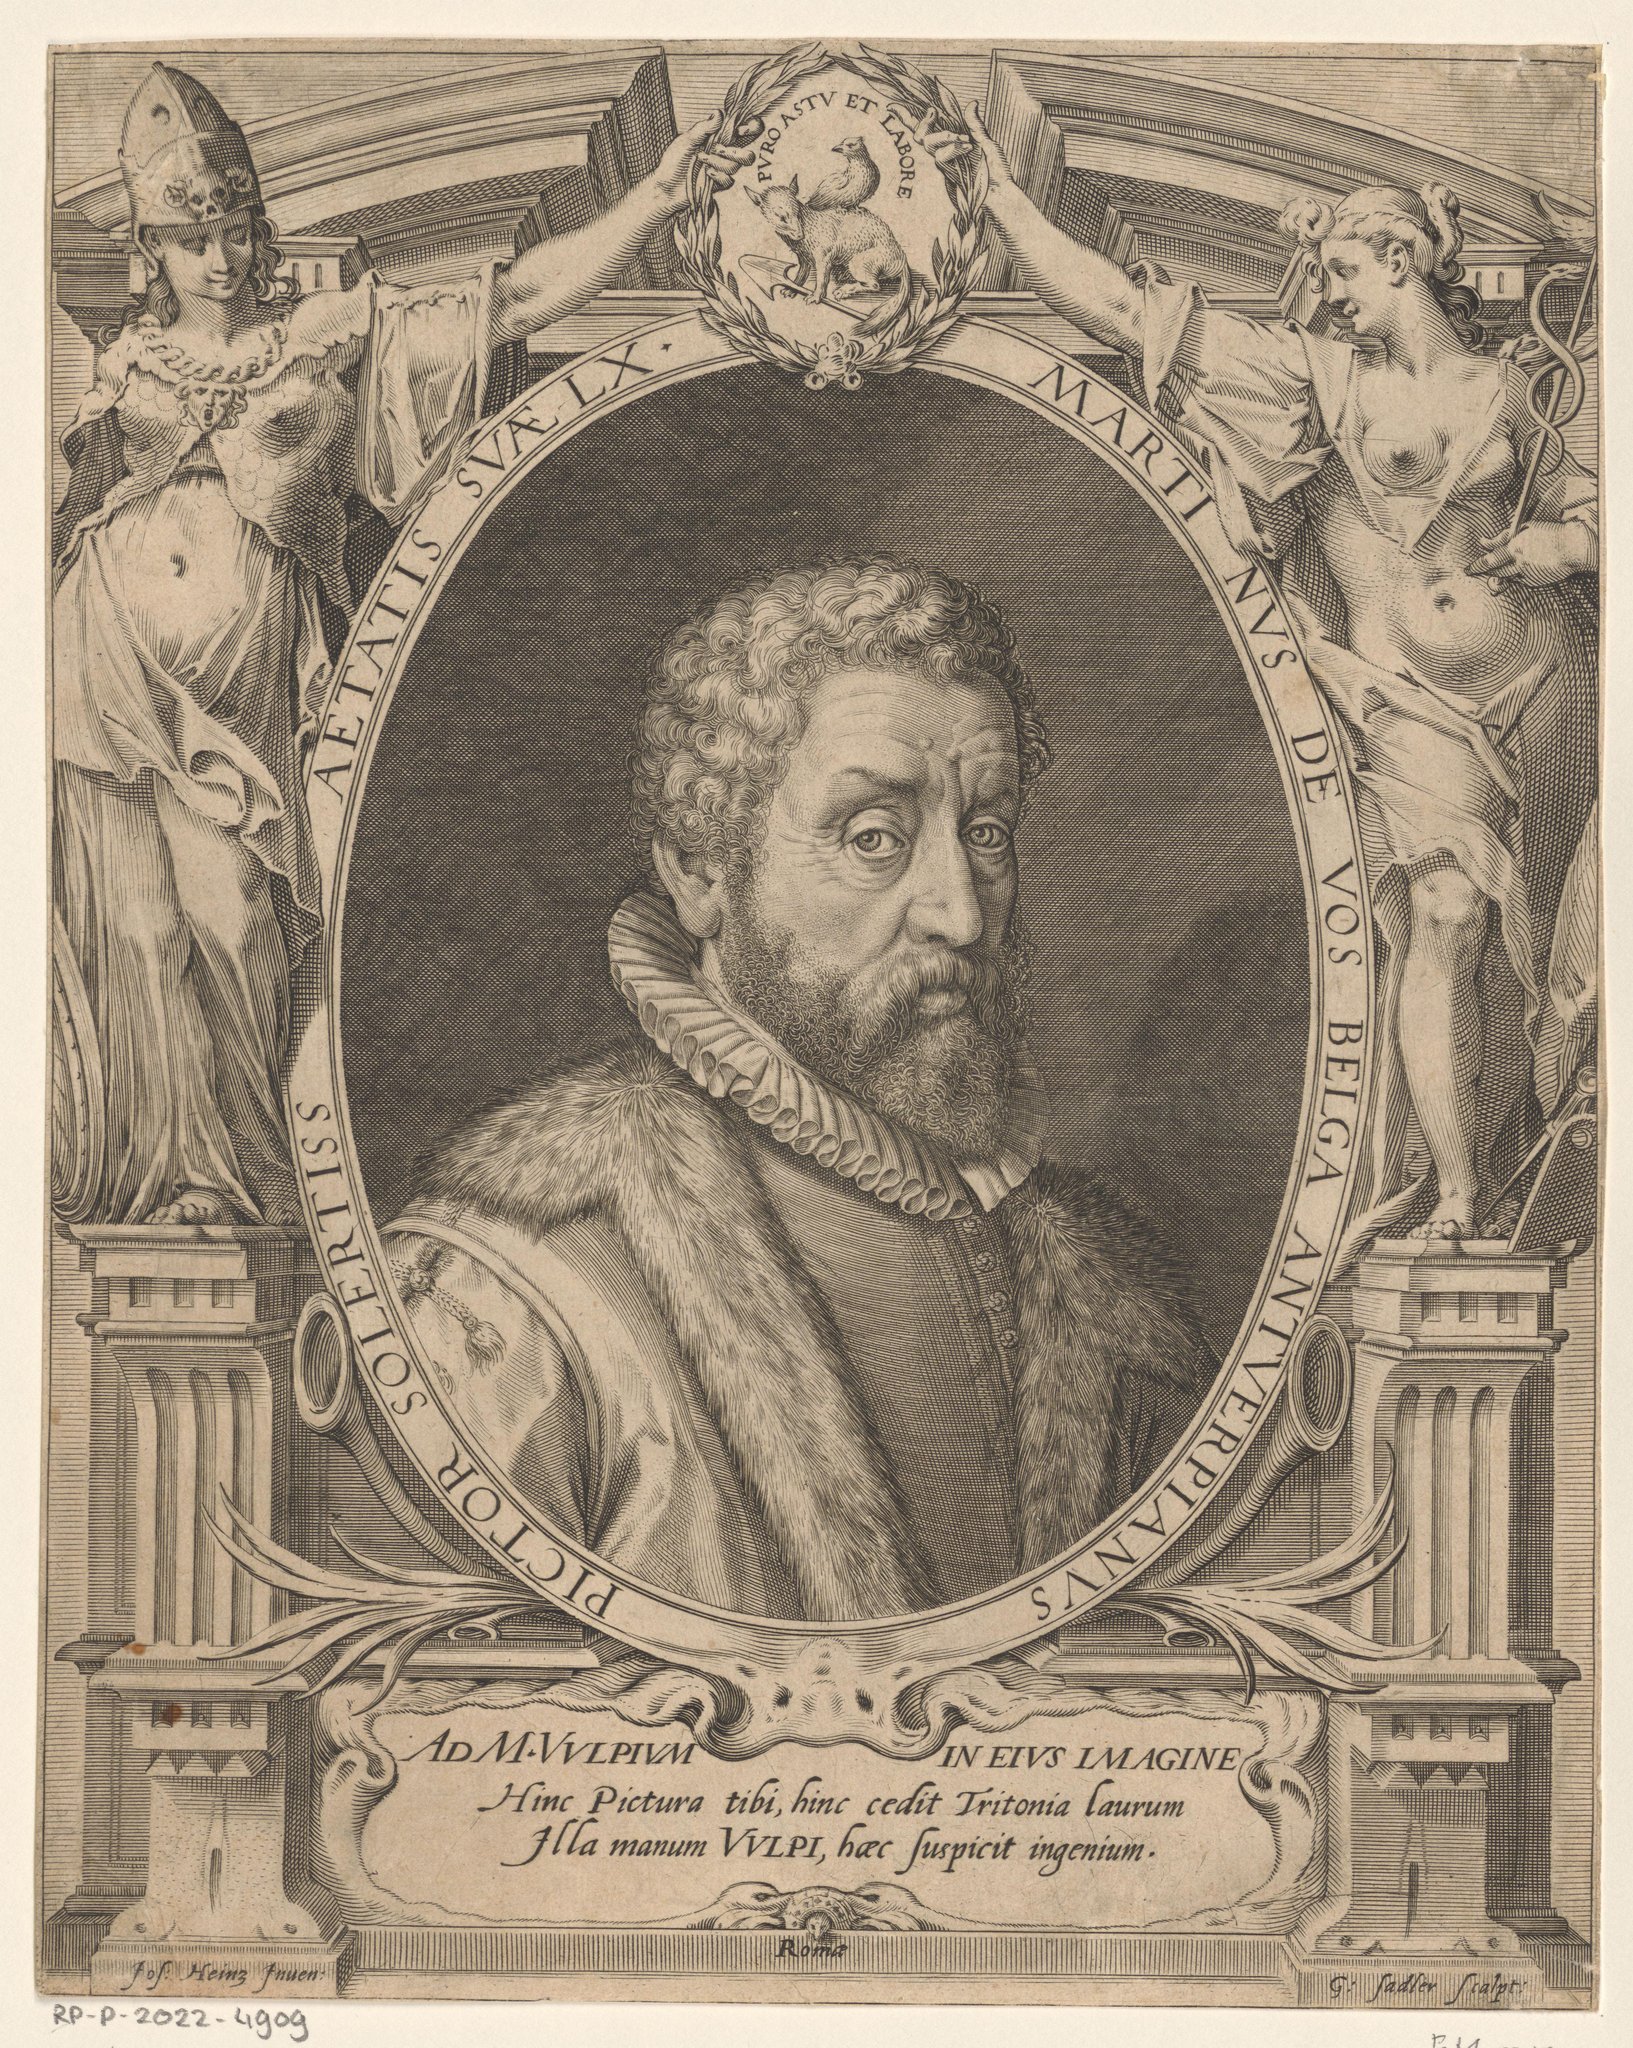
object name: print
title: Portret van Maerten de Vos op 60-jarige leeftijd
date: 1578-1609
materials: paper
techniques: engraving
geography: rome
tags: antwerp, draughtsman, maerten de vos, historical persons, portrait, self-portrait of painter, portrait, self-portrait of graphic artist, portrait, self-portrait of draughtsman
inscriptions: collector's mark: Lugt 2228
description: Met drieregelig onderschrift in het Latijn.